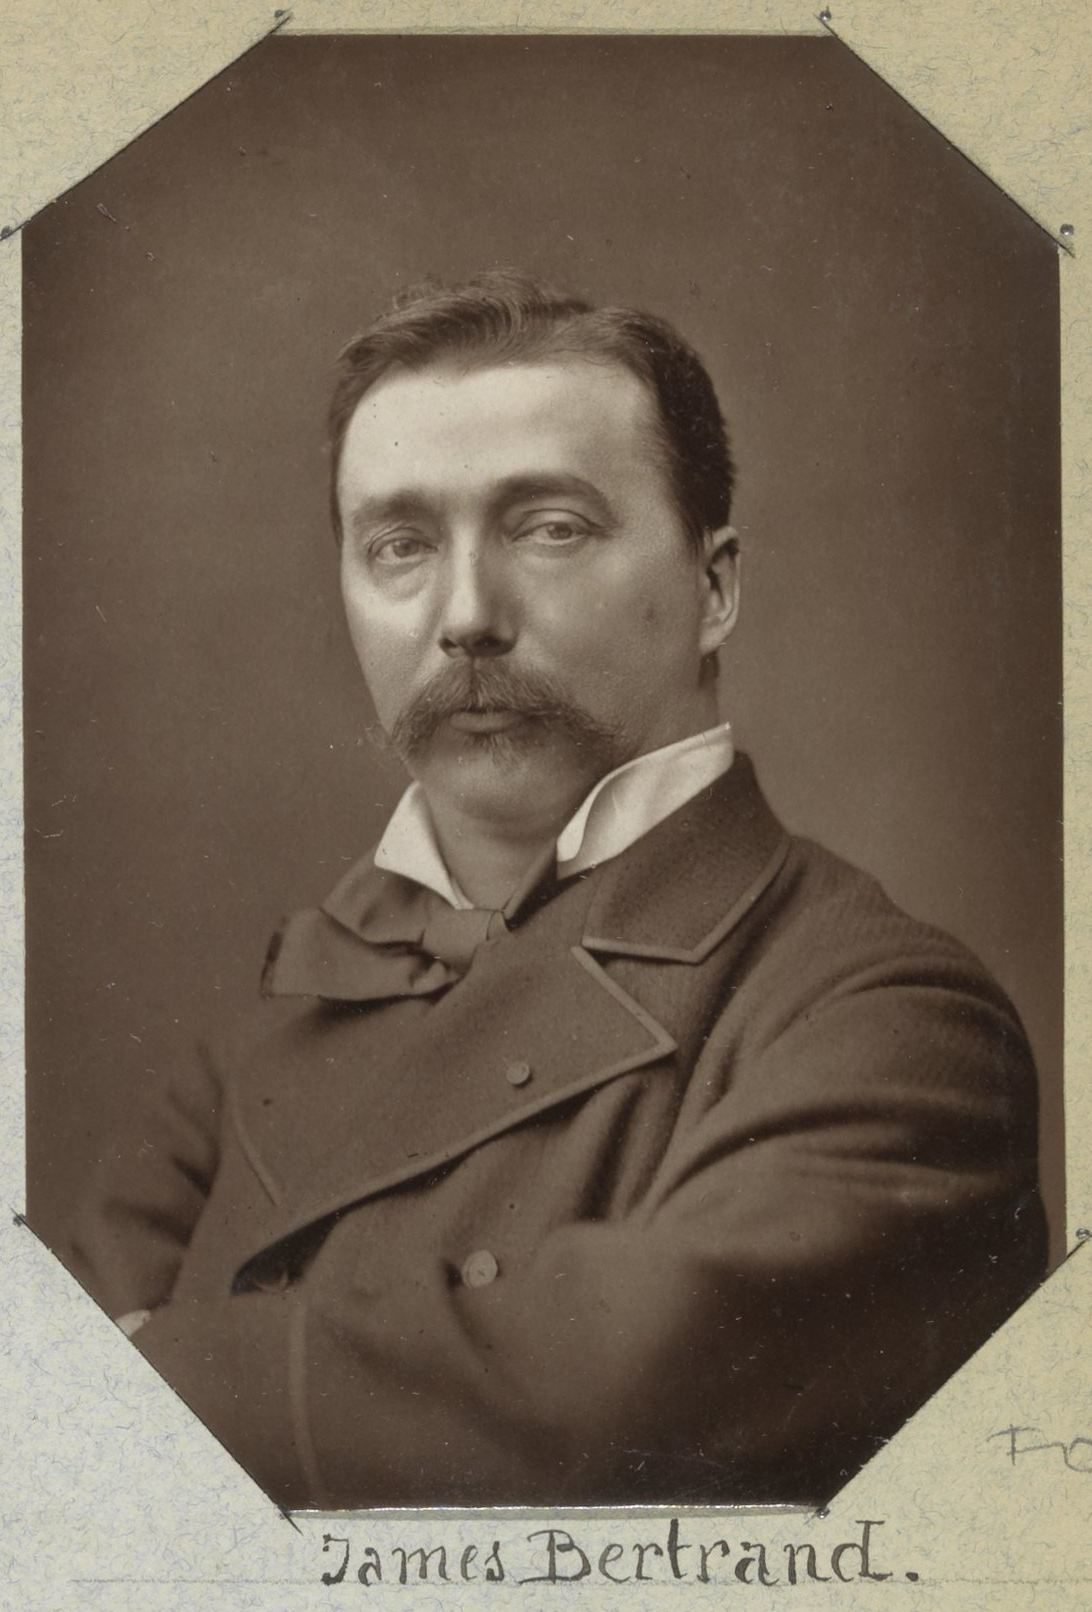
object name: photograph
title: Portret van James Bertrand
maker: Anonymous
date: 1880-1900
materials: paper, photographic support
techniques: carbon print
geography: france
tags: adult man, france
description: Onderdeel van Album van een Franse amateur met foto's van Frankrijk, Algerije, Palmyra, de Wereldtentoonstelling van 1900 en van bekende Fransen.